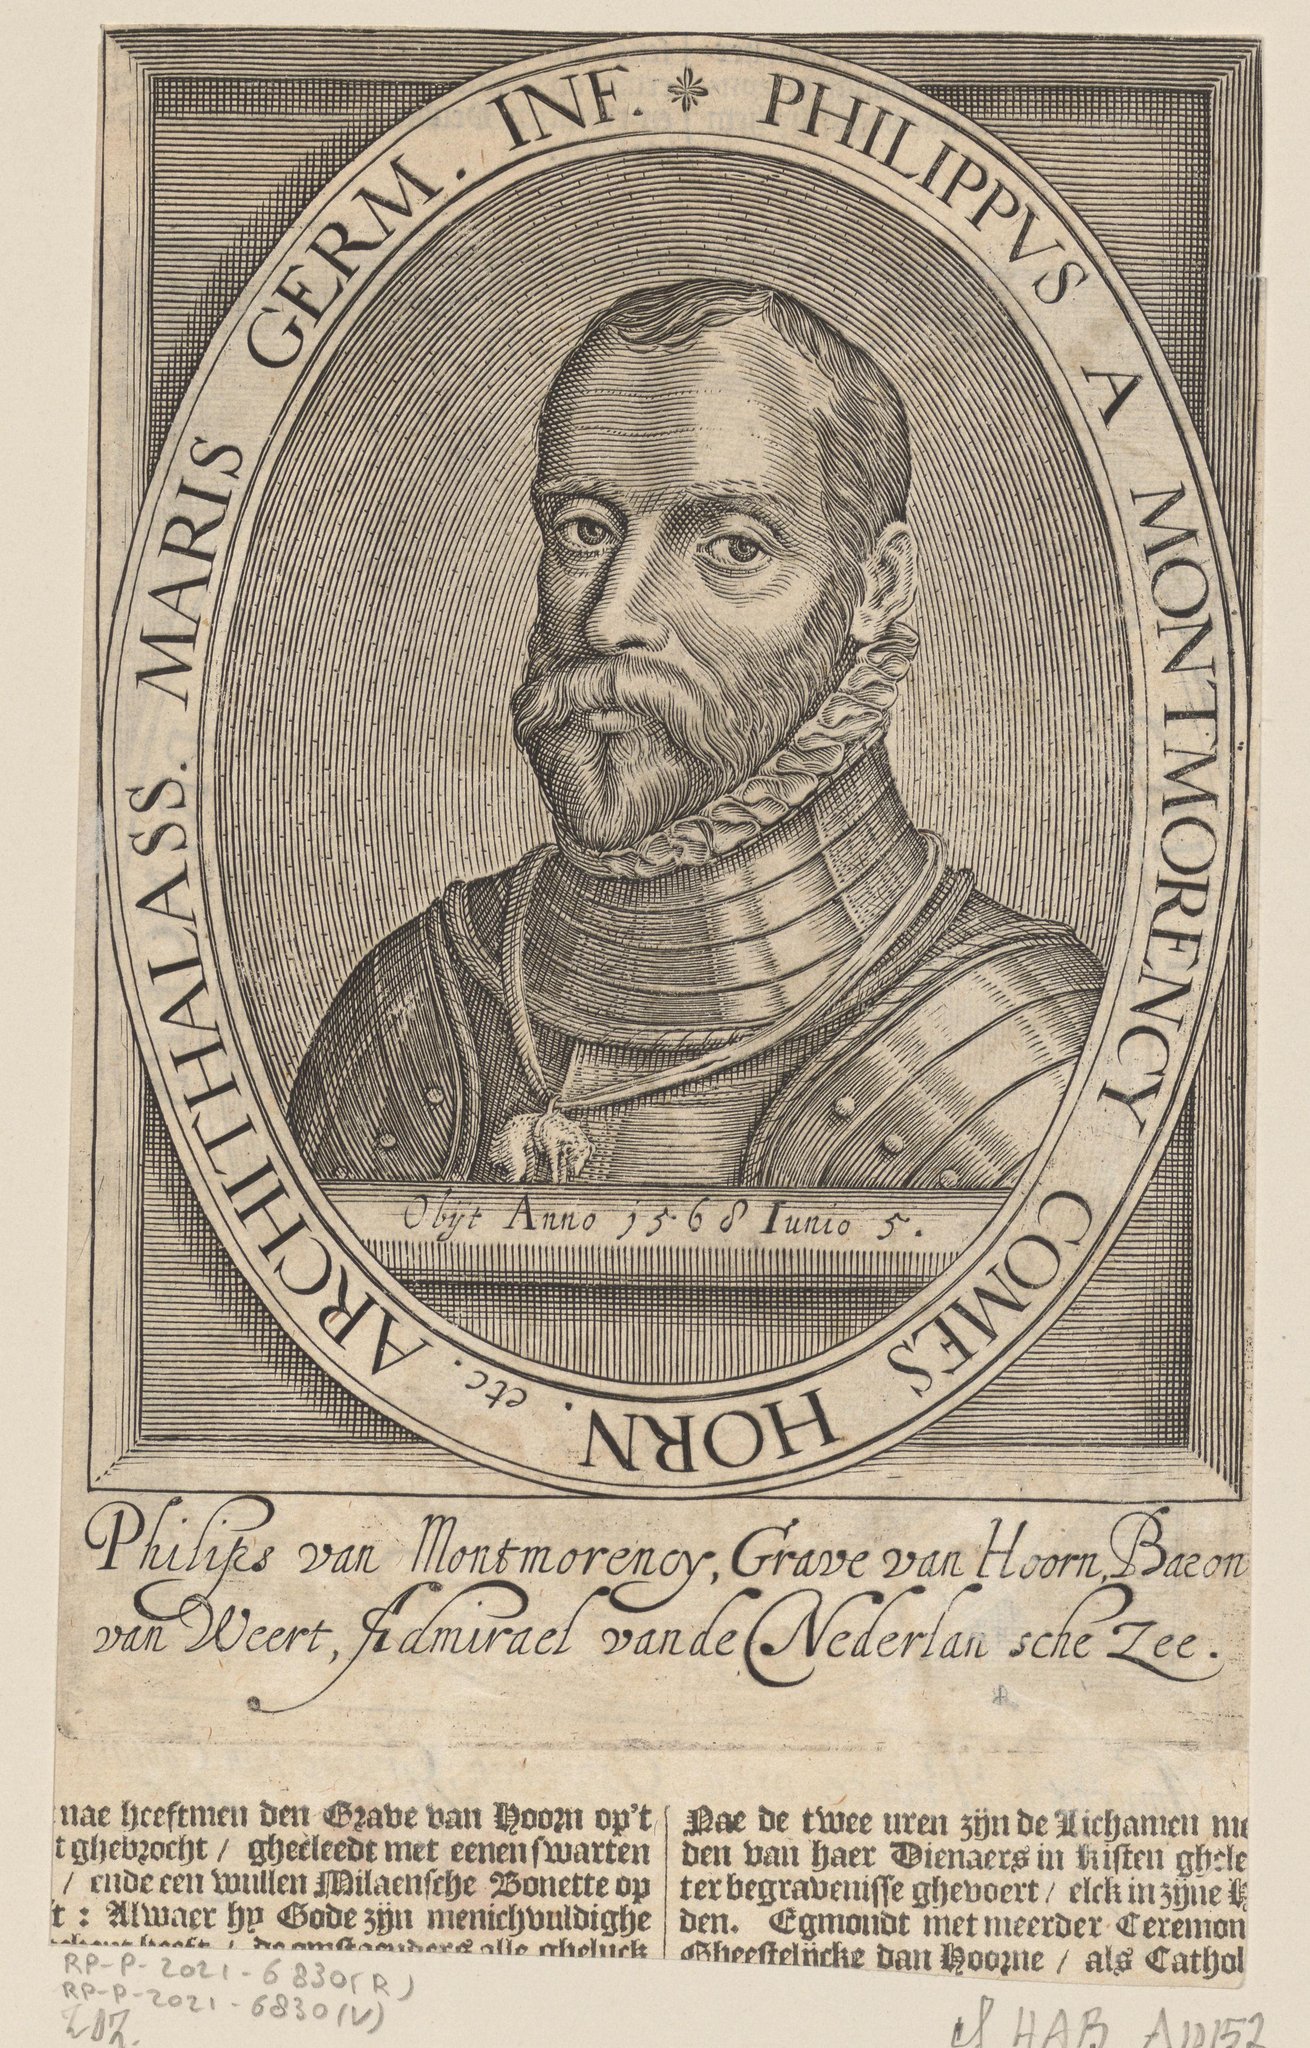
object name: print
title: Portret van Filips van Montmorency, graaf van Horne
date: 1614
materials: paper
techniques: engraving, letterpress printing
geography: the hague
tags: brussels, armour, historical persons, knighthood order of the golden fleece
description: Prent uit: Meteren, Emanuel van. Historie der Neder-landscher ende haerder na-buren oorlogen ende geschiedenissen (...). Den Haag: Hillebrant Jacobsz. van Wouw (I), 1614. Prent mogelijk ook gebruikt in andere edities.